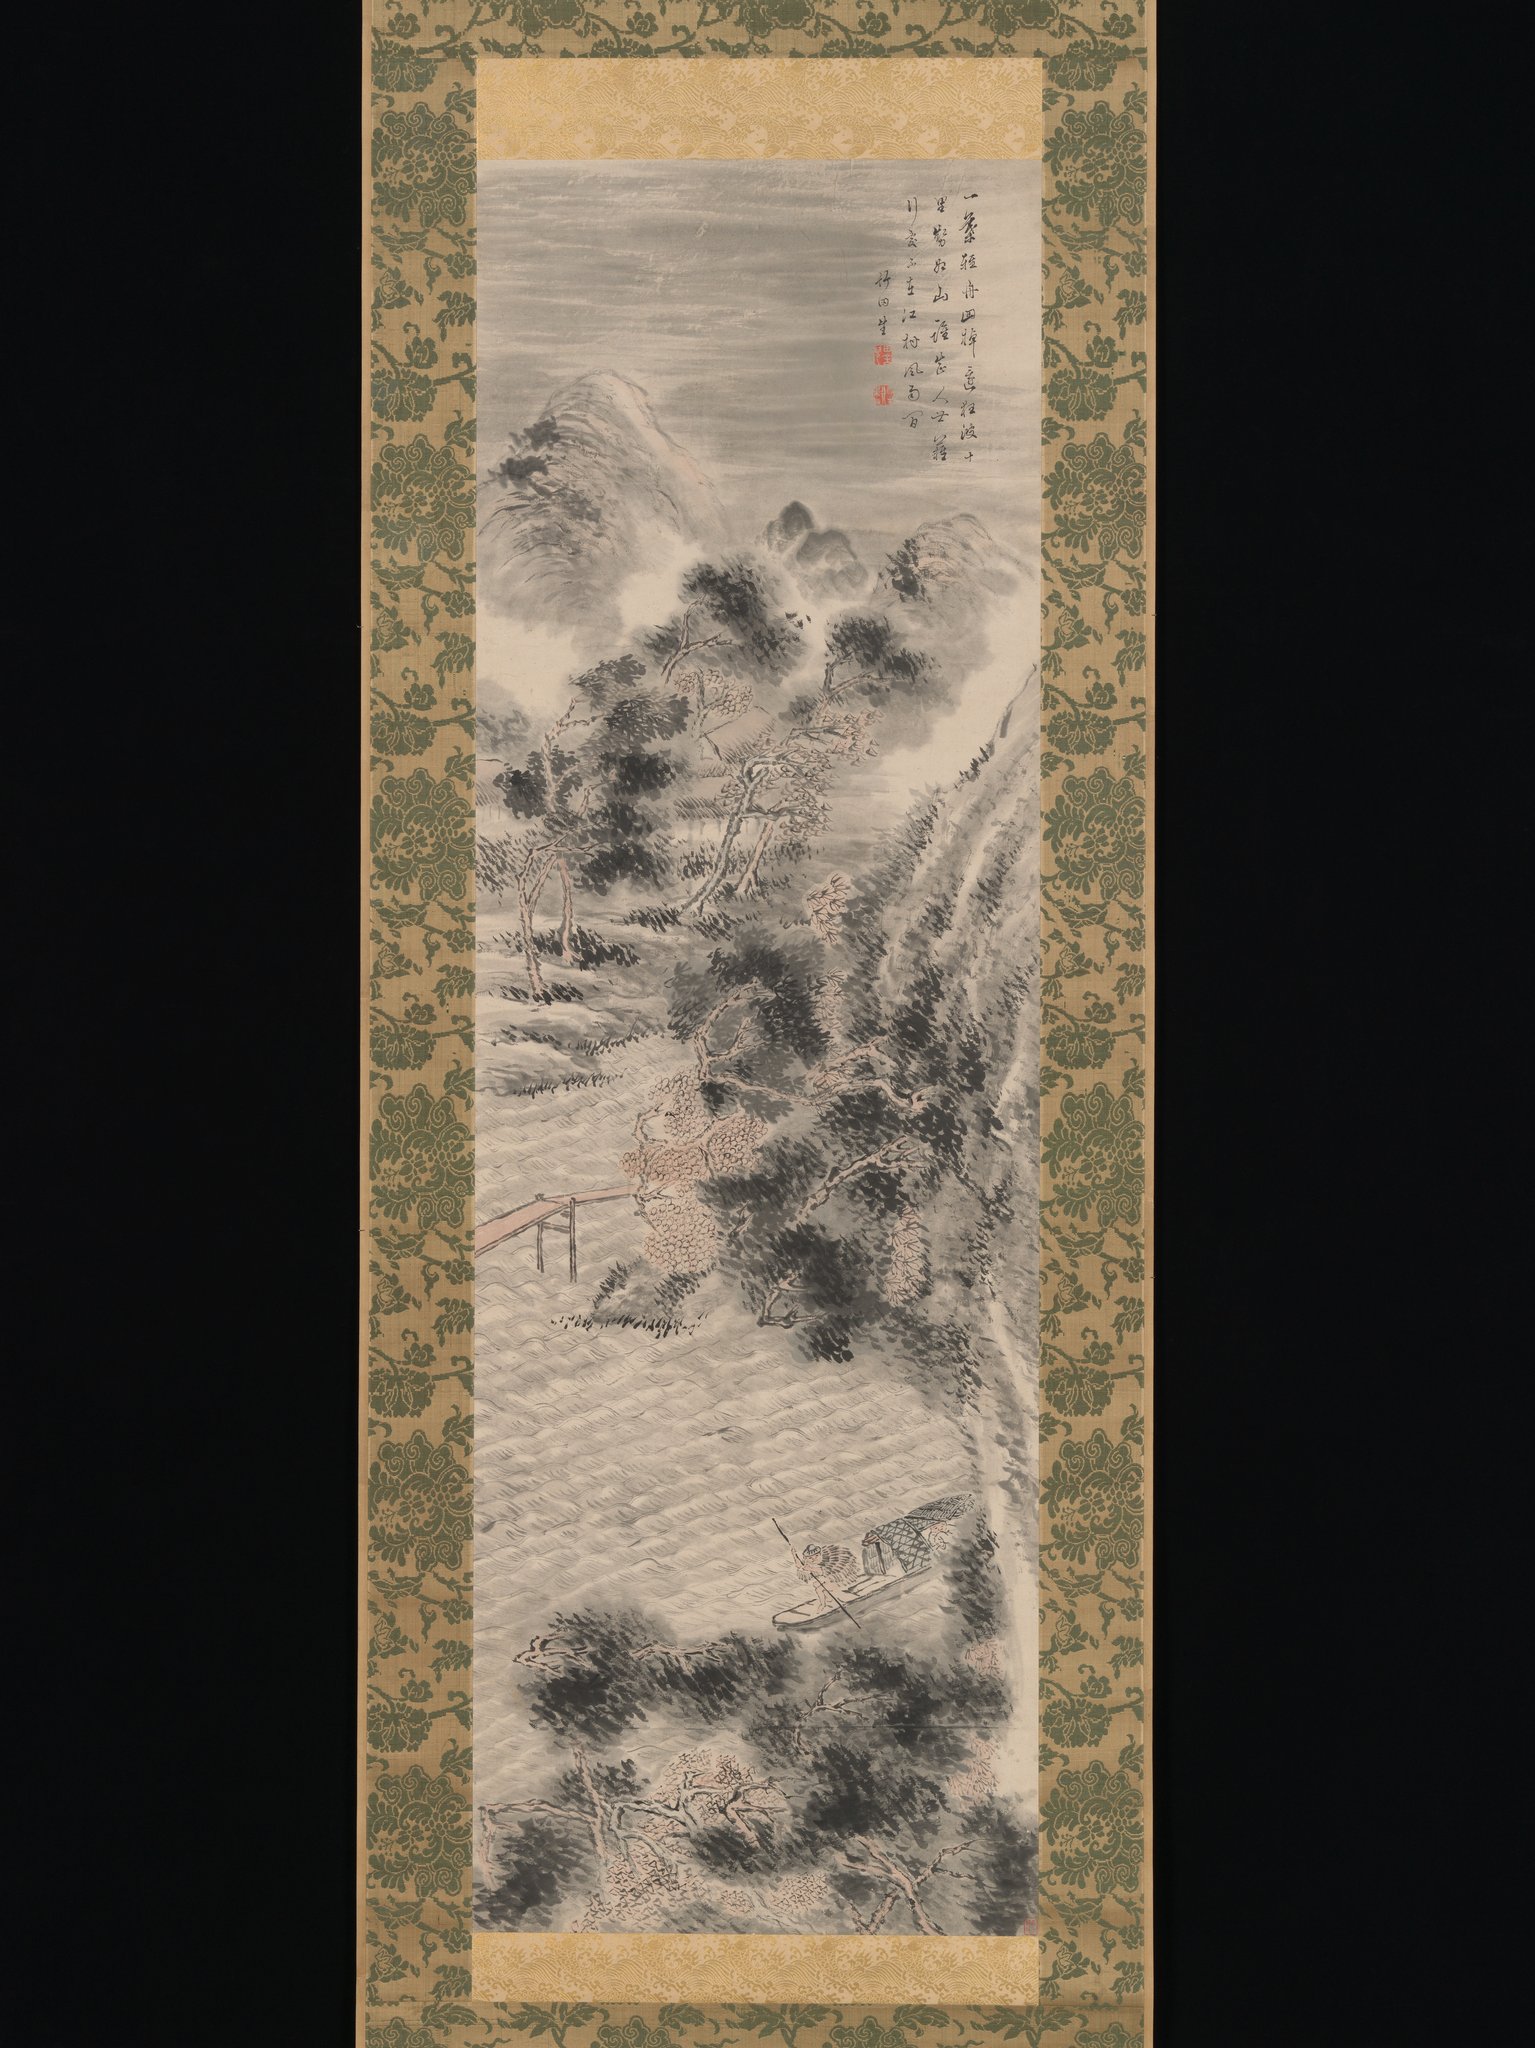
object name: hanging scroll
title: Rainstorm over a River Village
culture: japanese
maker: tanomura chikuden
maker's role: artist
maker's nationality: japanese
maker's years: 1777-1835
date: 1767-1833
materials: ink, paper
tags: rivers,landscapes,rain